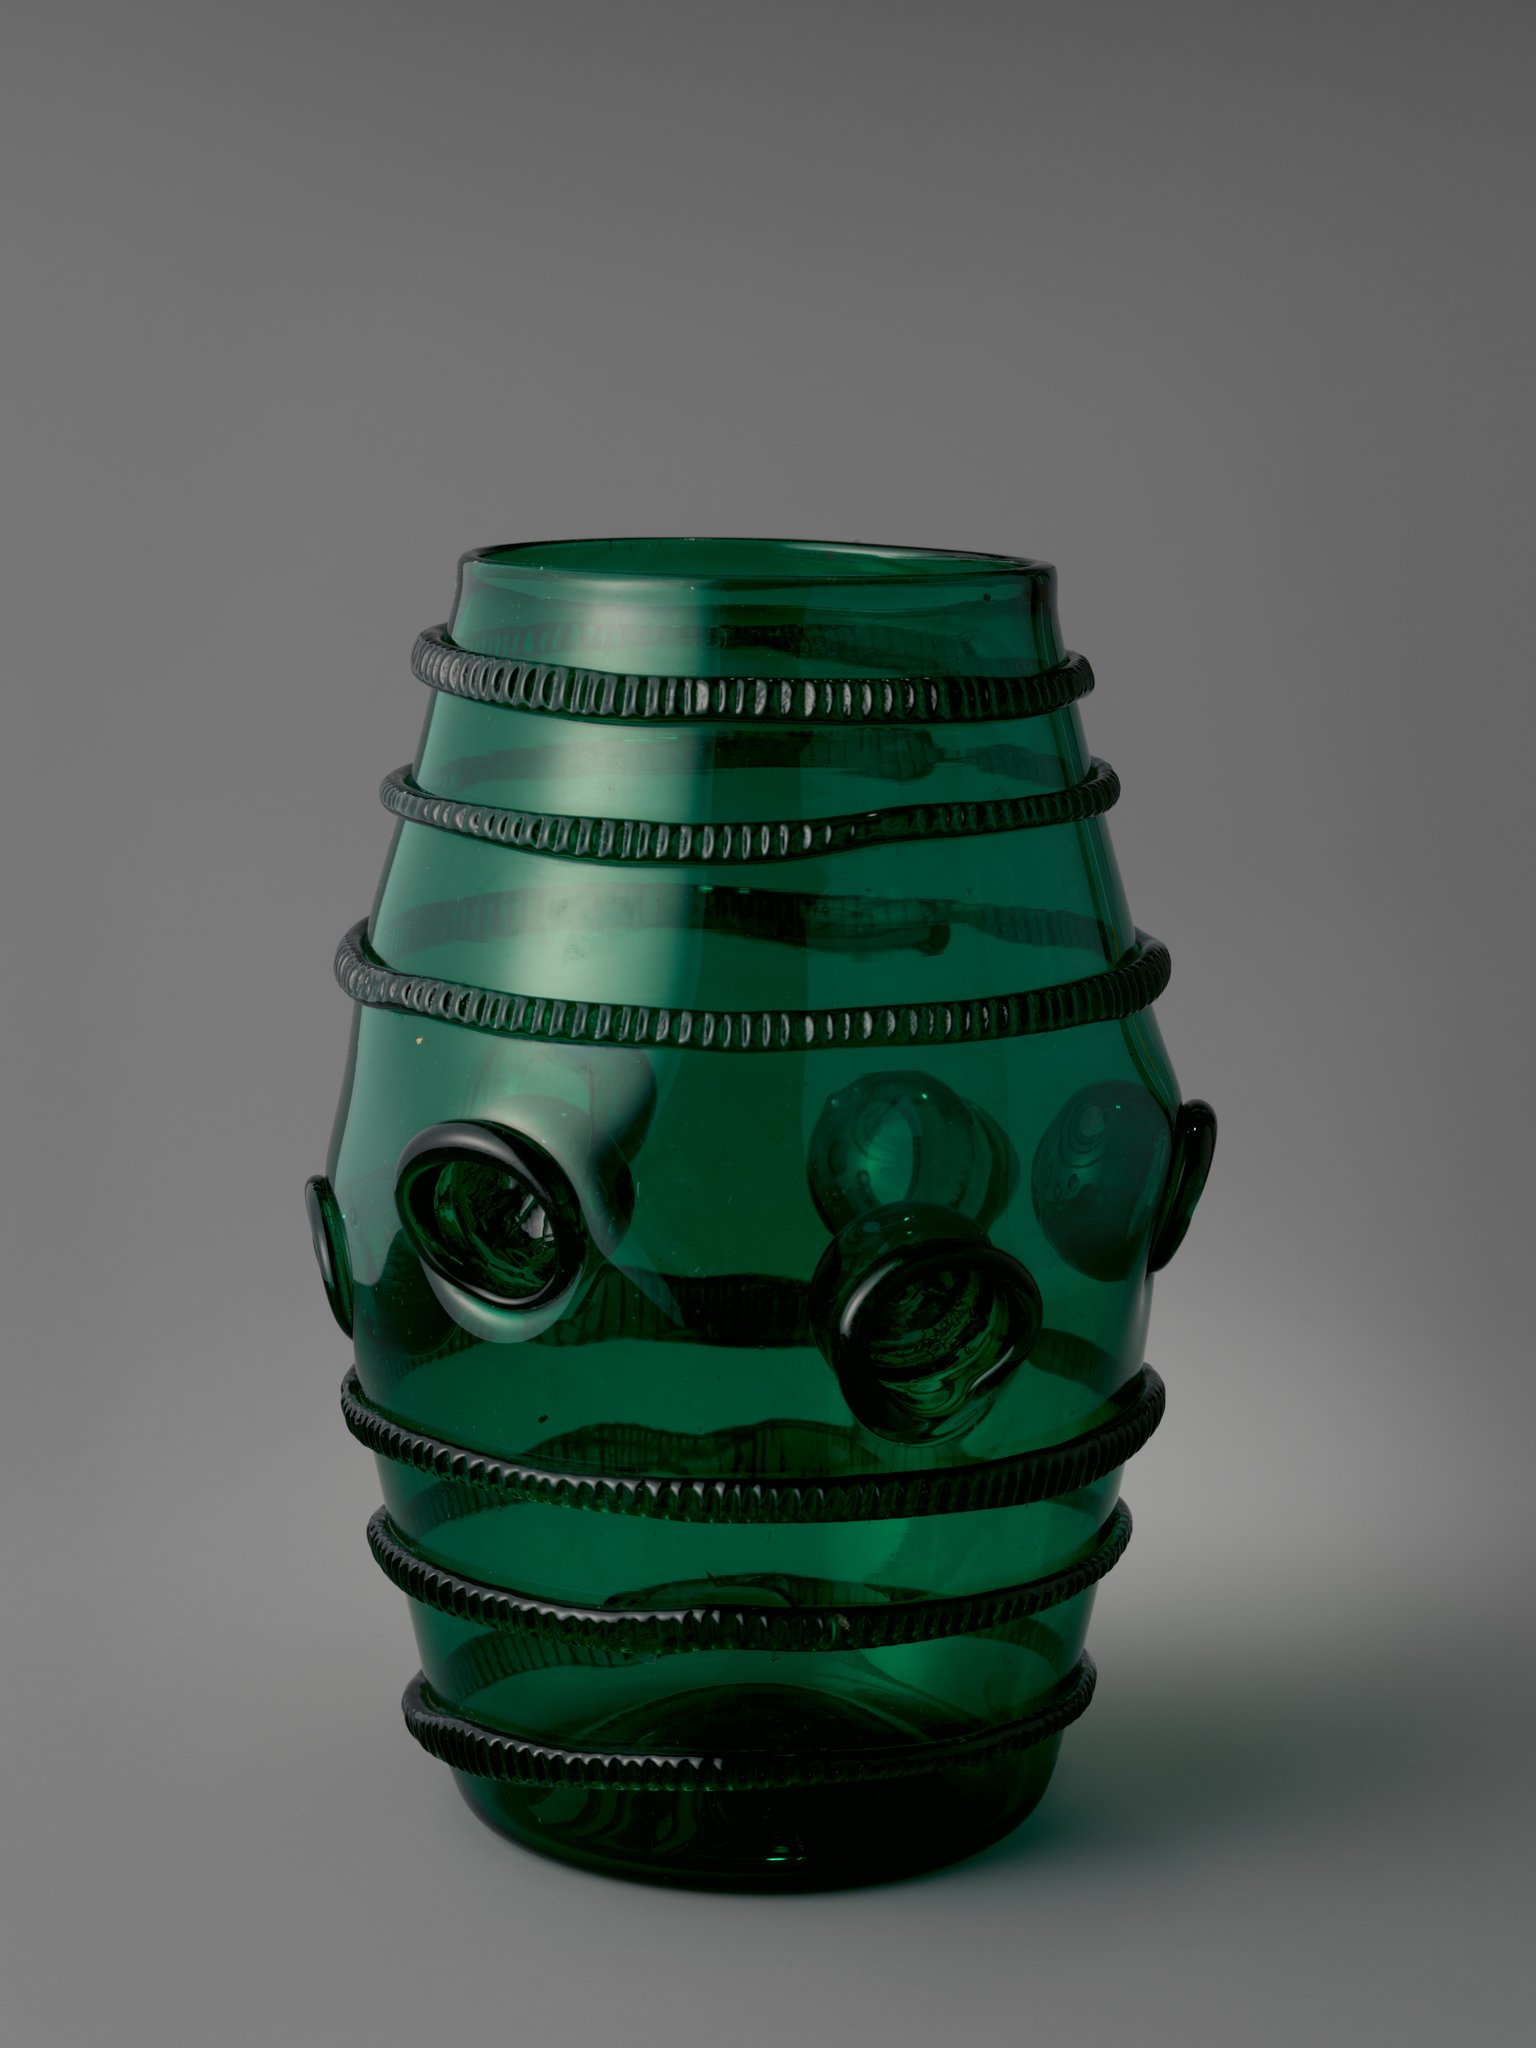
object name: thumb glass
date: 1601-1800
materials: glass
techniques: glassblowing